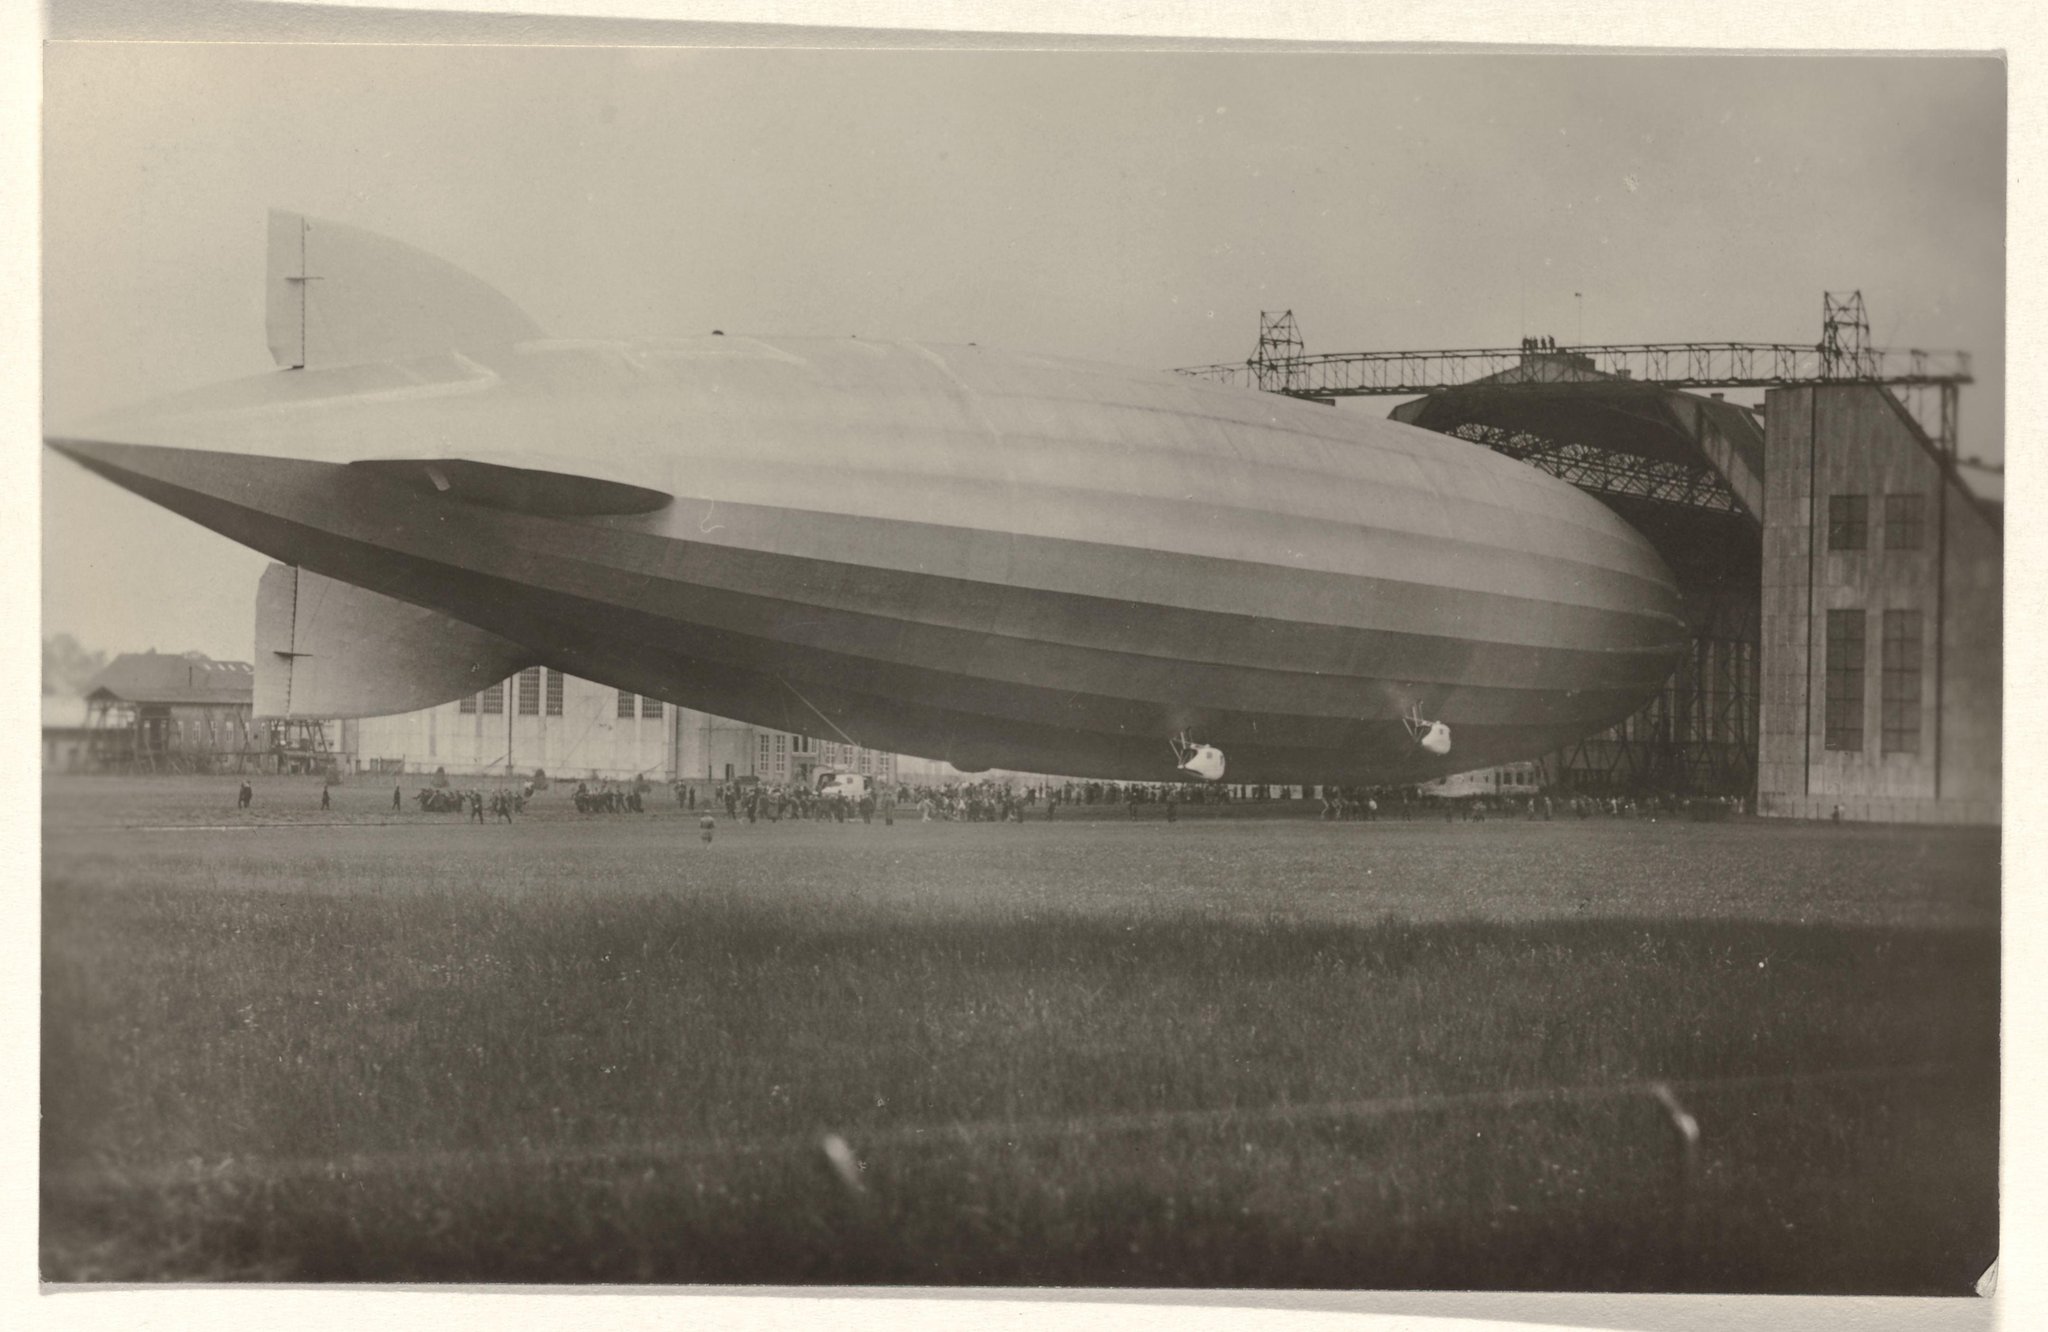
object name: photograph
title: De Amerika-zeppelin Z.R. III verlaat zijn hangar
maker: Anonymous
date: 1924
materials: photographic support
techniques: gelatin silver print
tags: konstanz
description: De Amerika-zeppelin Z.R. III verlaat zijn hangar.